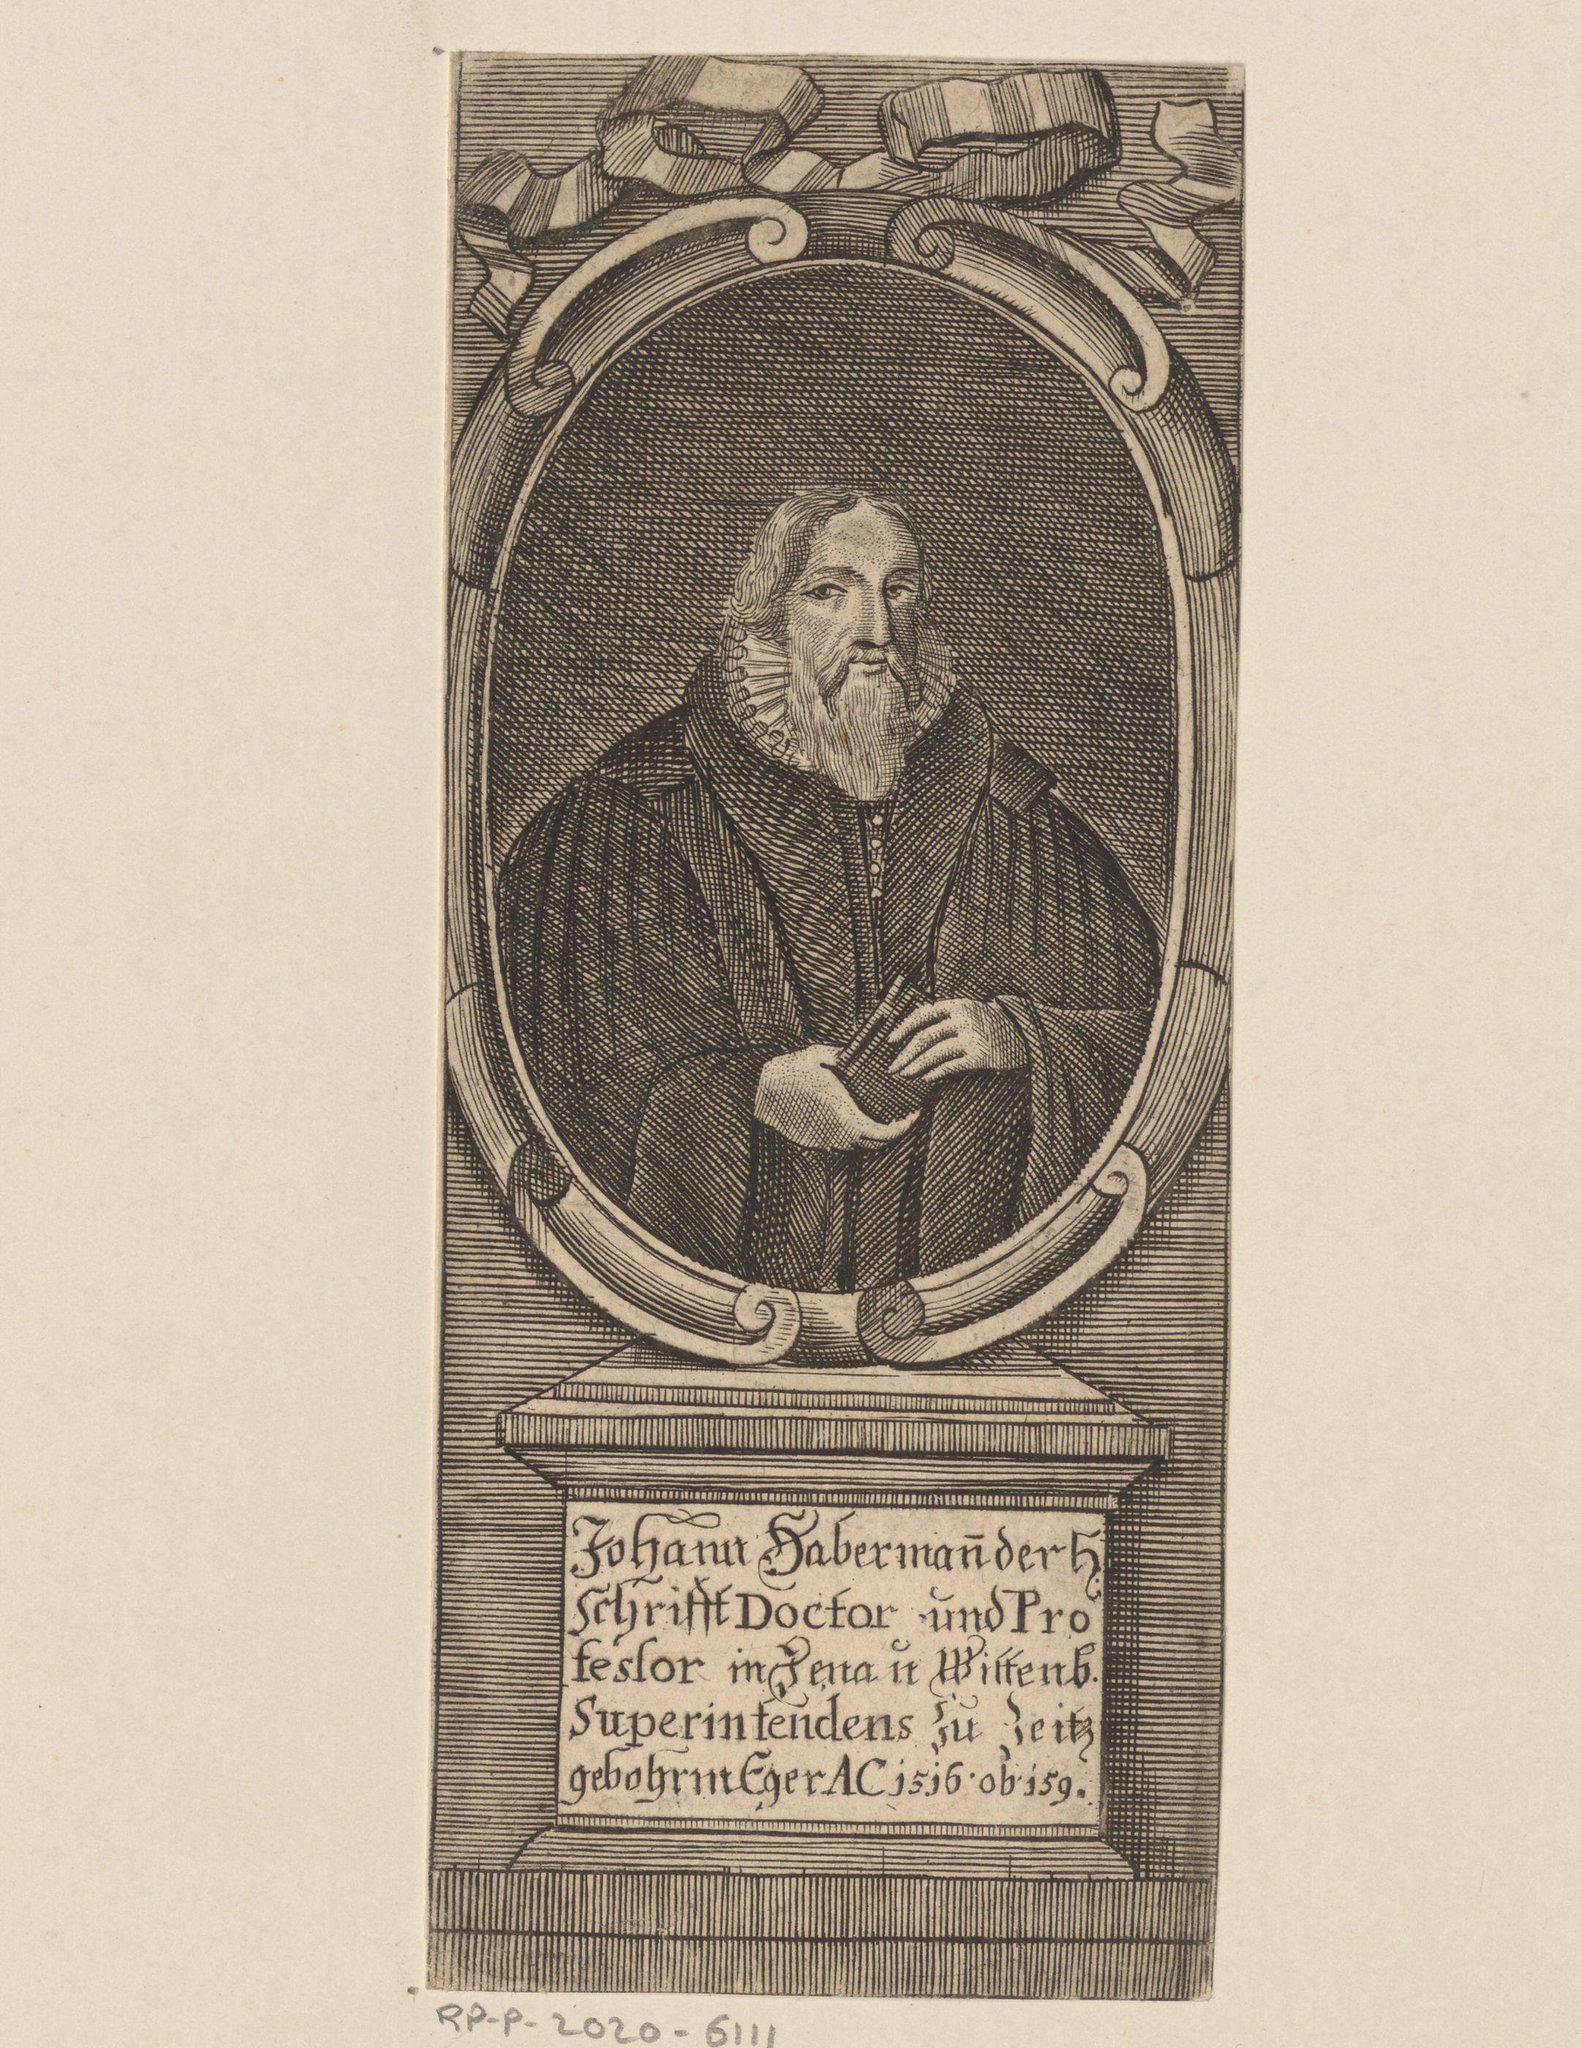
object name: print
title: Portret van Johann Habermann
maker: Anonymous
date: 1650-1699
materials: paper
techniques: engraving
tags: theologian, historical persons, book